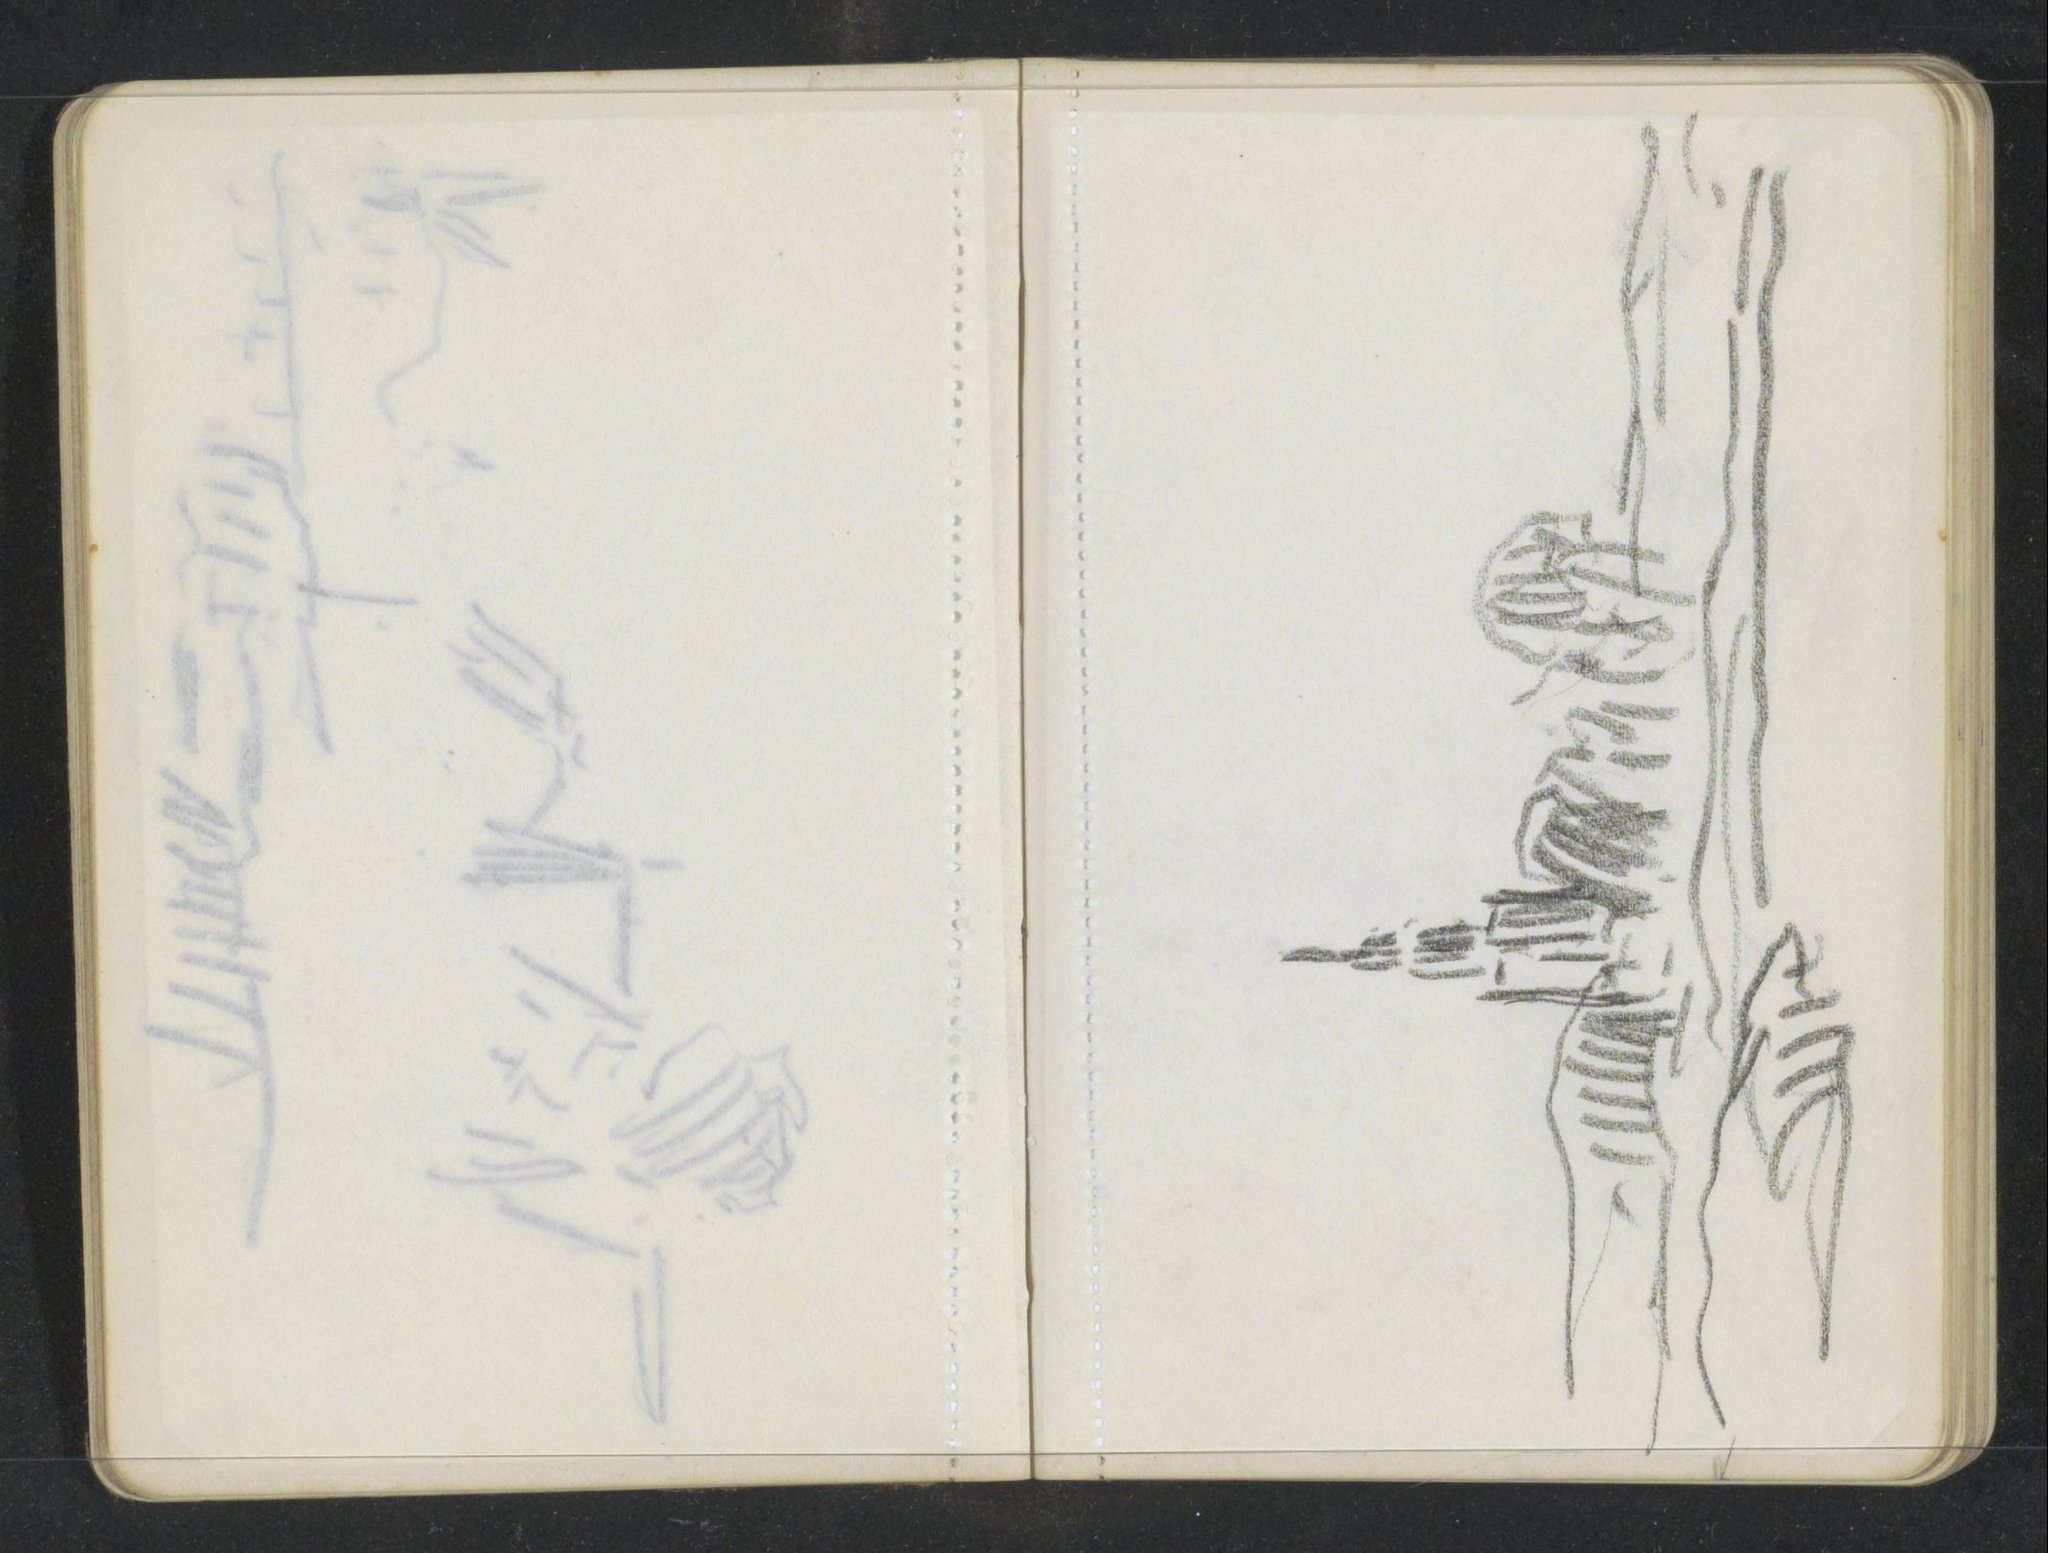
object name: sketchbook leaf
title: Landschap met kerk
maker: alexander shilling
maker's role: draughtsman, print maker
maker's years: 1859-1937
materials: chalk, paper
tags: city-view, and landscape with man-made constructions, parts of church exterior and annexes: tower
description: Blad 13 recto uit een schetsboek met 91 bladen.